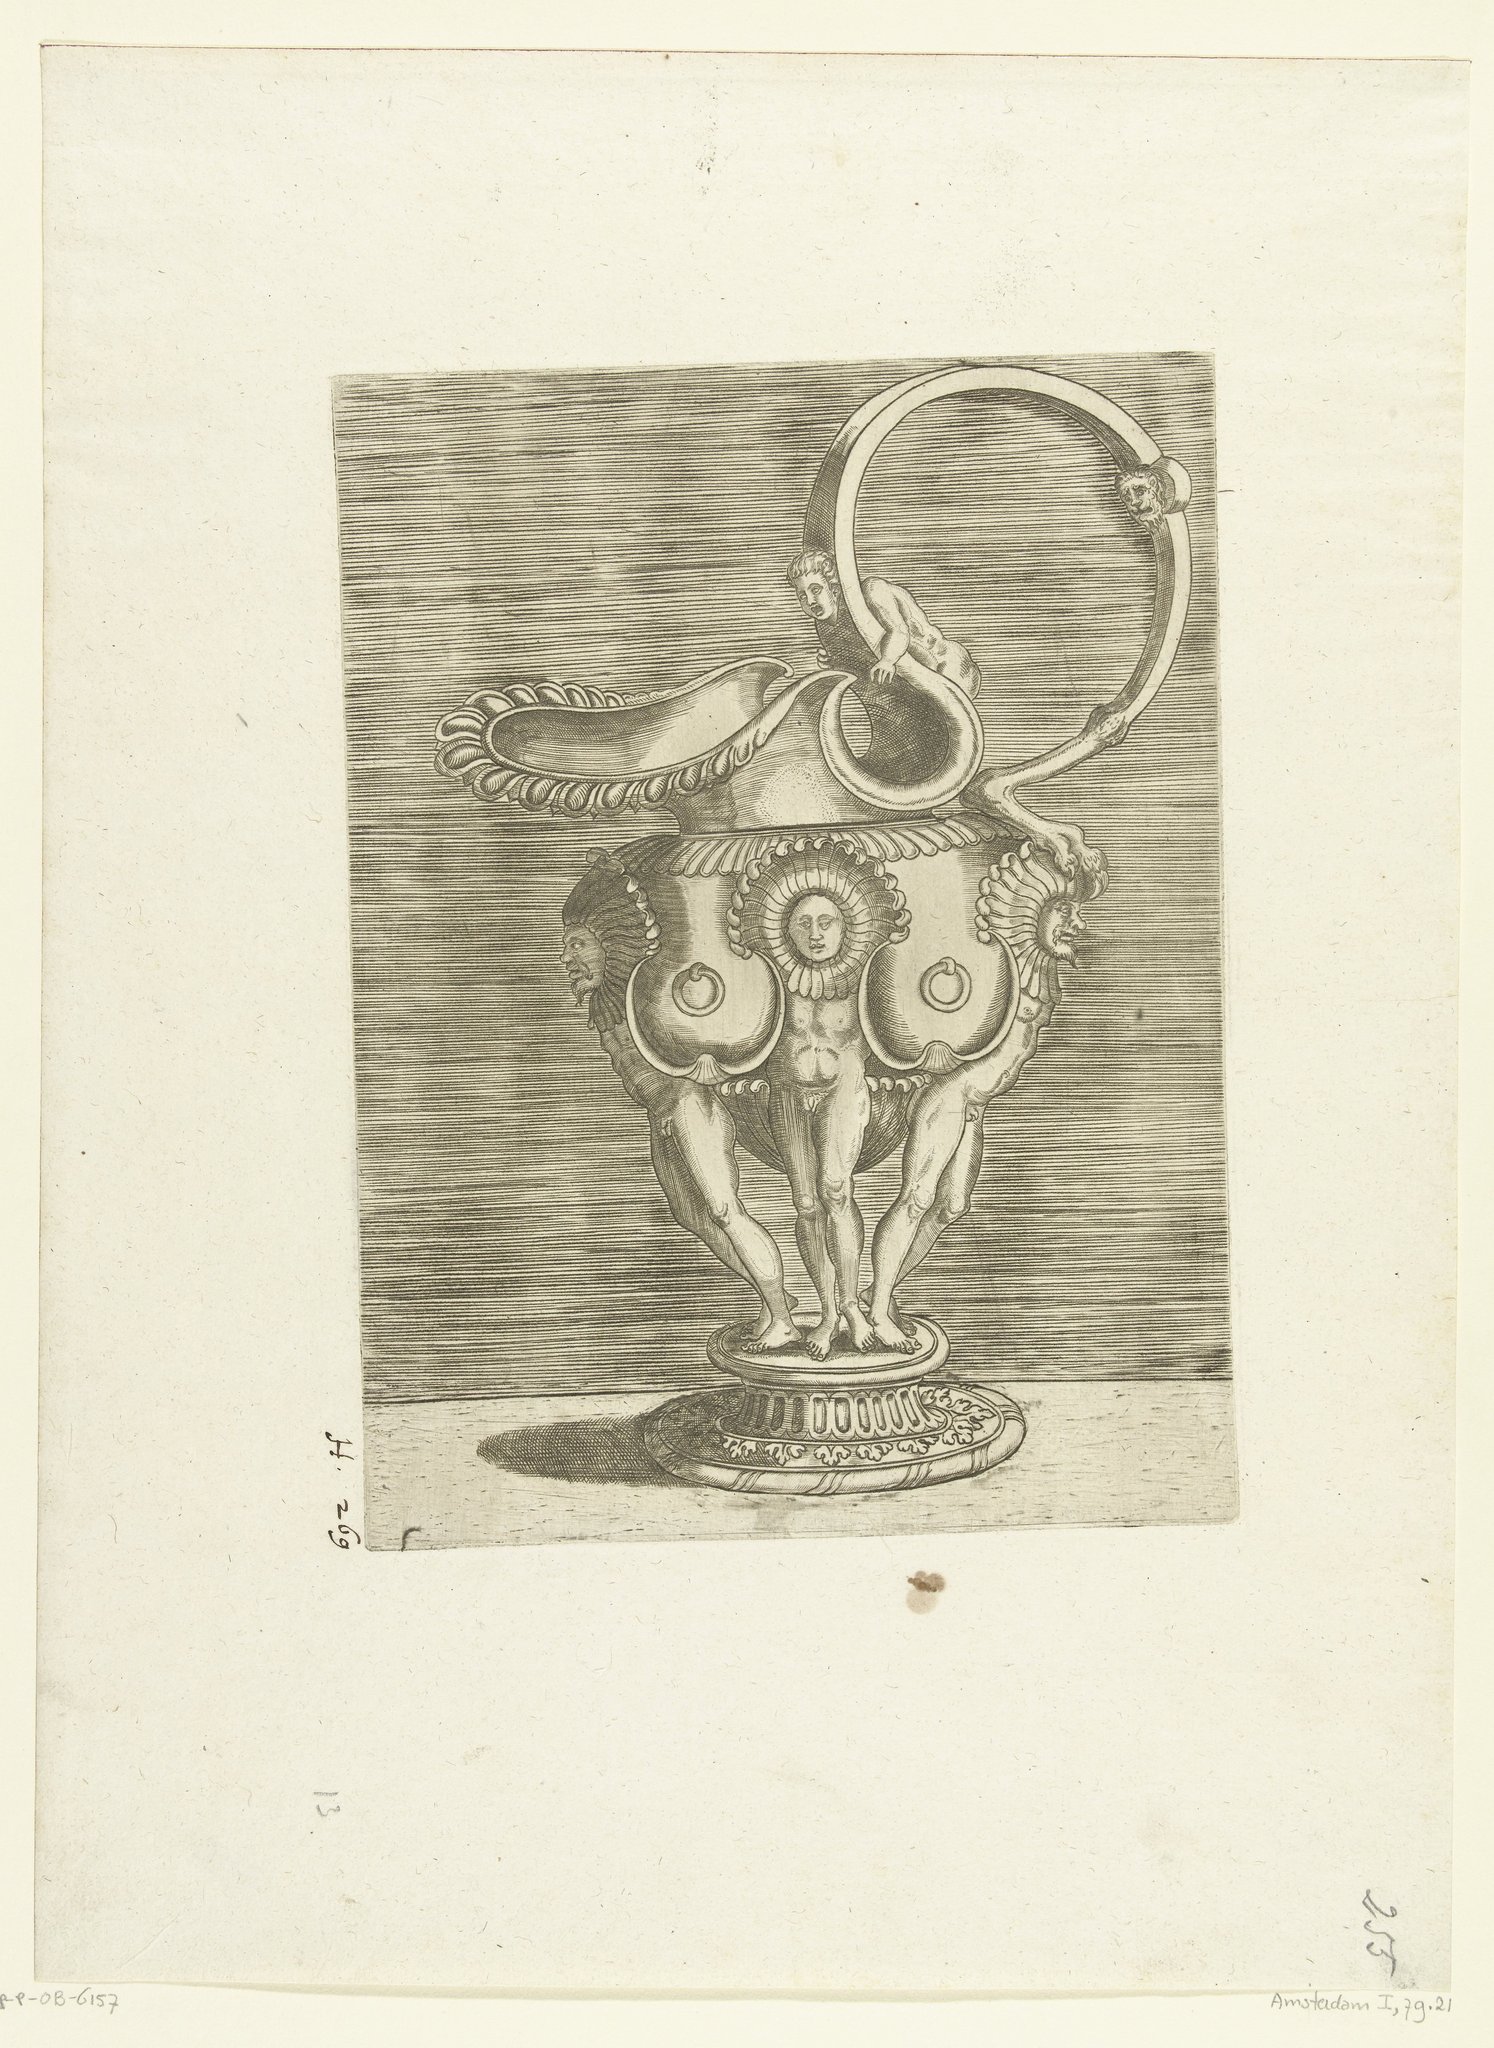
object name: ornament print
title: Kan met oor, gedragen door drie figuren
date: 1548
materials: paper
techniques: engraving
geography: netherlands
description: De kan wordt gedragen door drie figuren die met hun hoofden door een op de buik van de kan vastzittende kraag kijken. Door het oor hangt een kind. Afkomstig uit een serie bestaande uit een titelblad en 20 bladen.